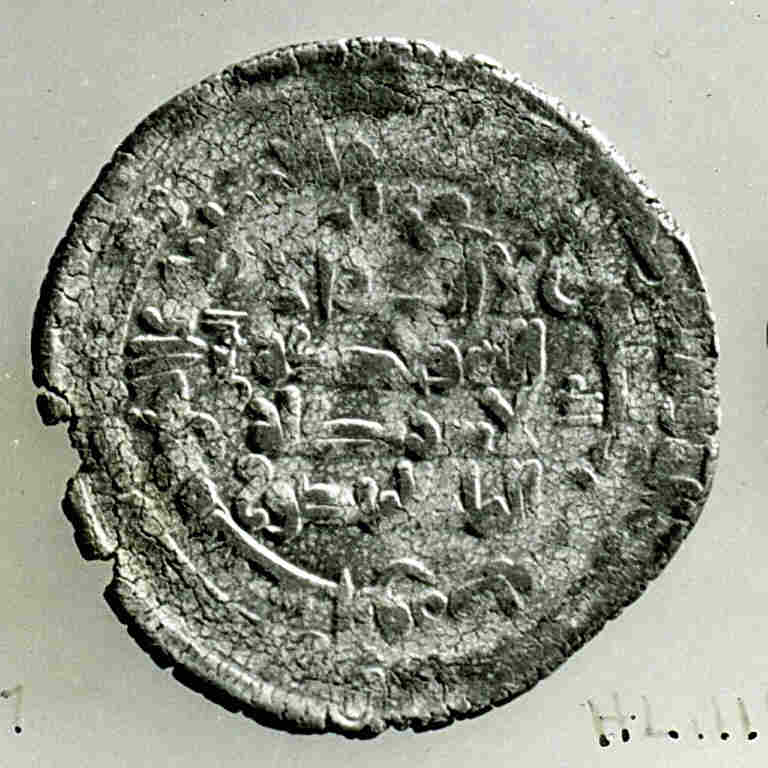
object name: coin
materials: silver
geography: iran